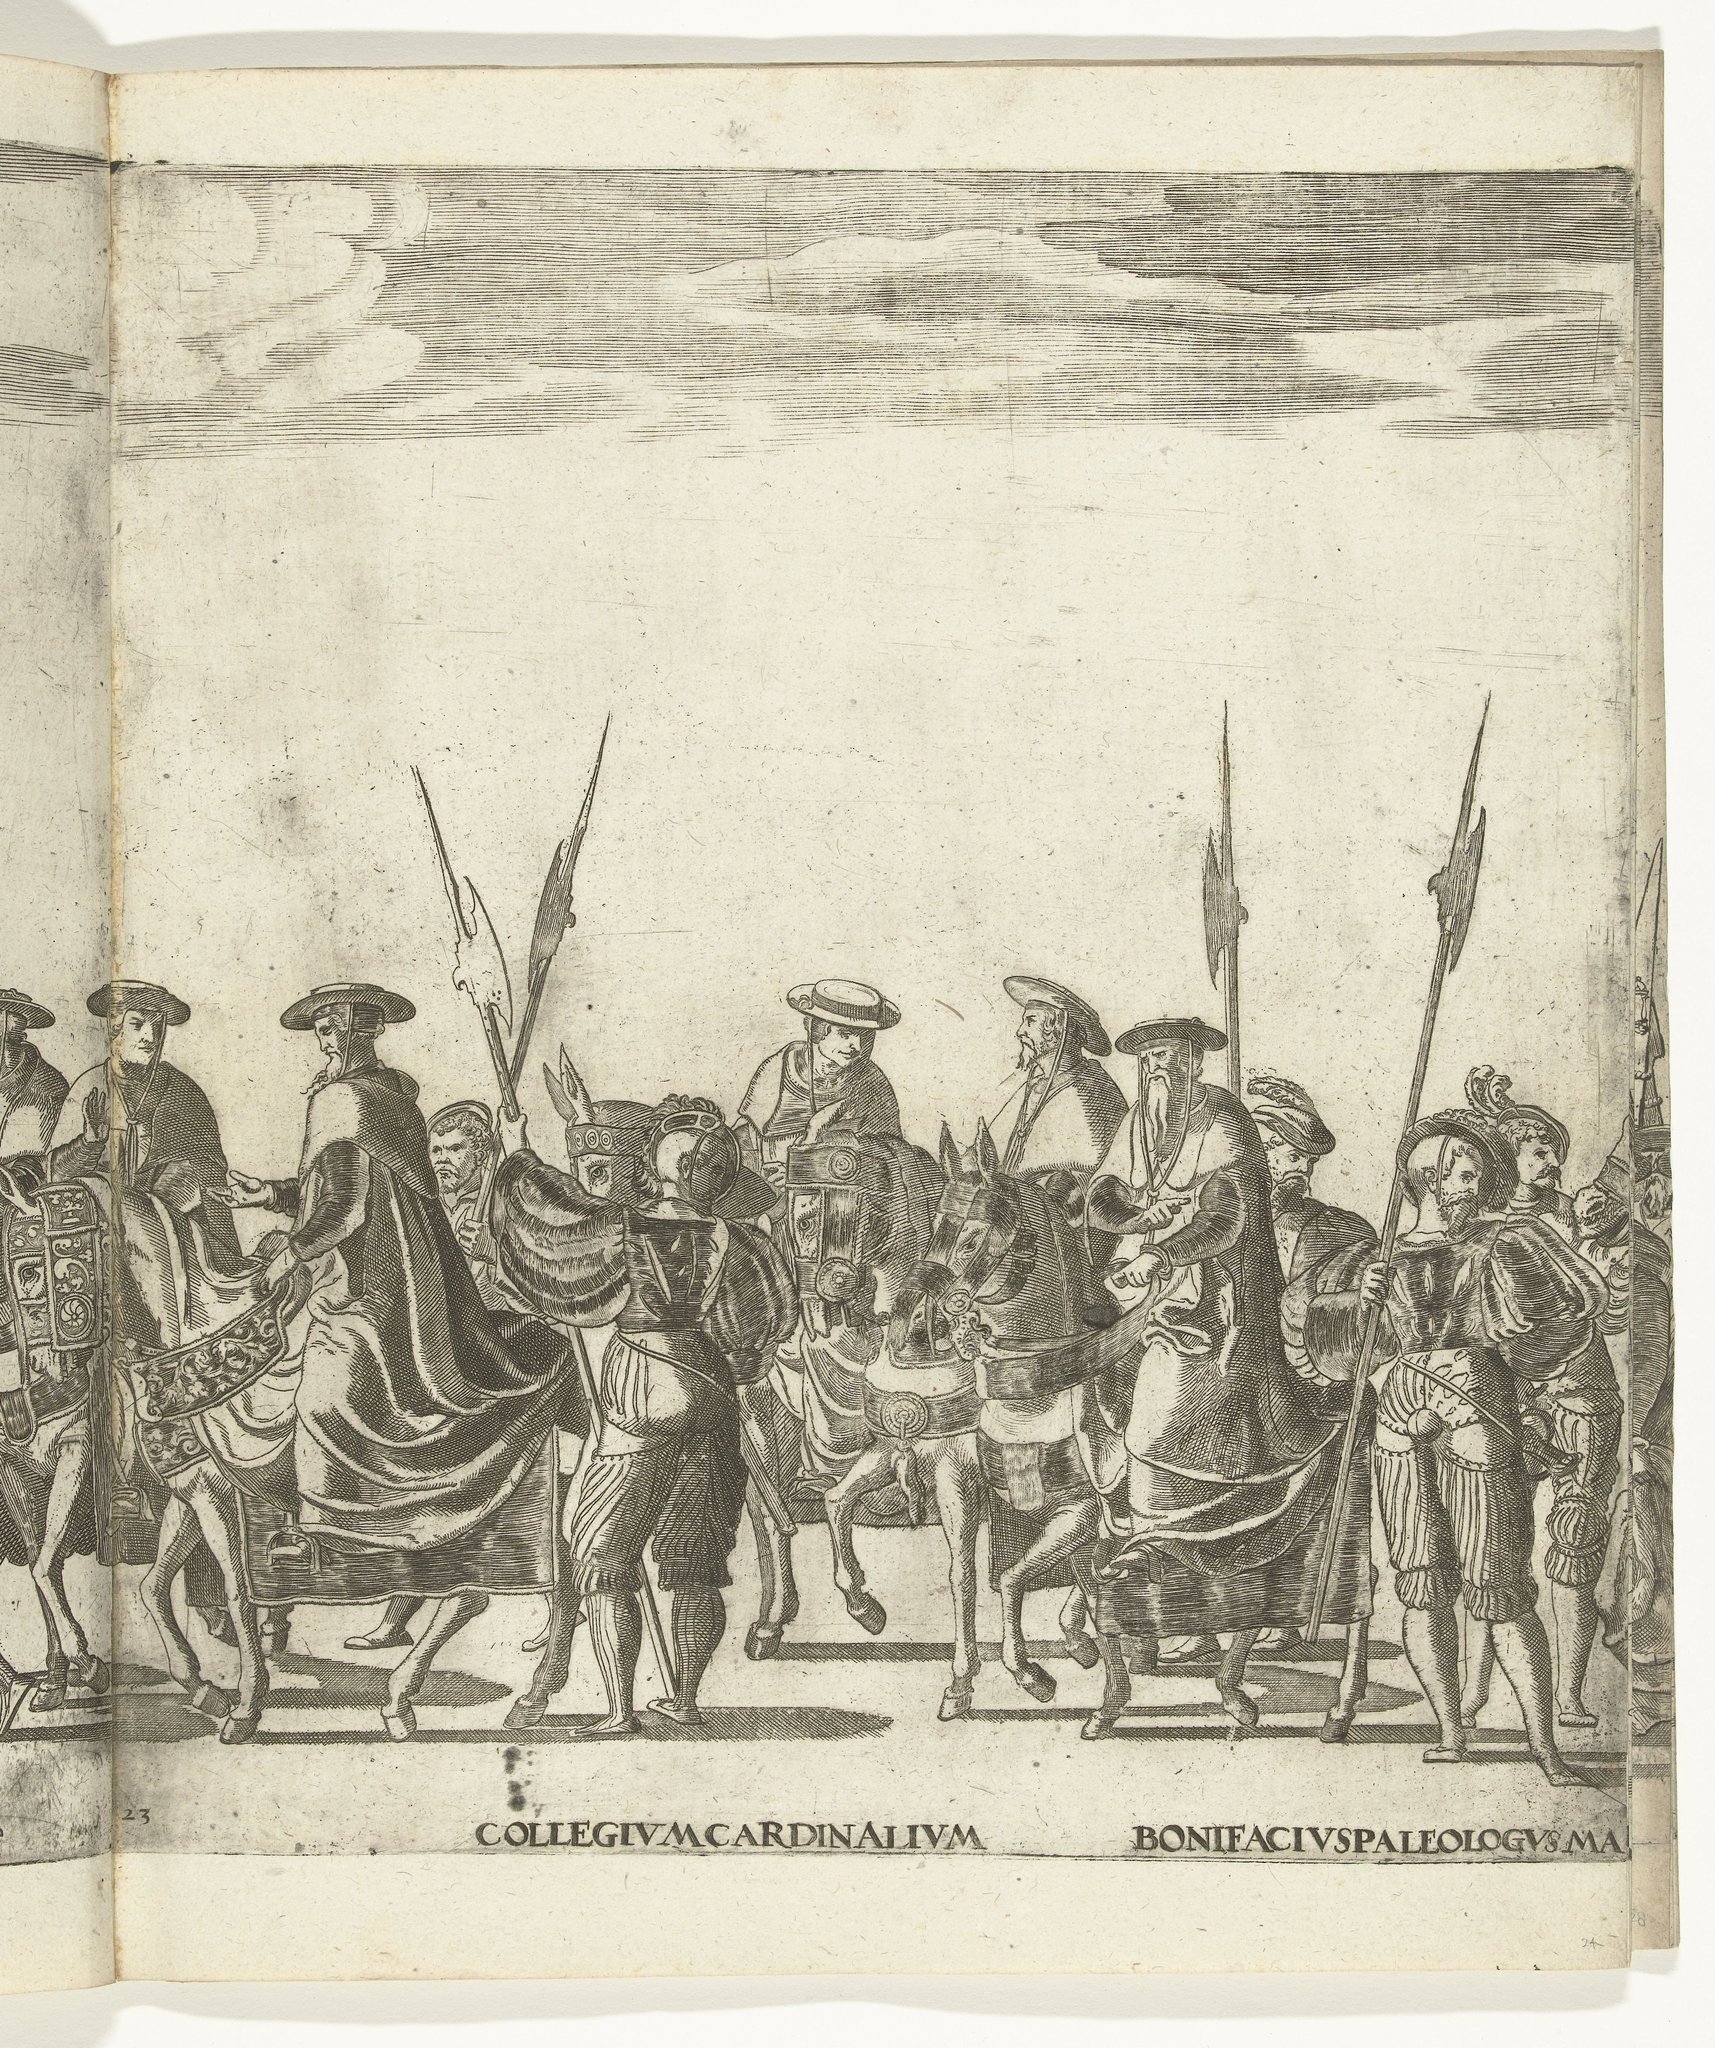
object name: print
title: College van kardinalen, plaat 23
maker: nicolaas hogenberg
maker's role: draughtsman, painter, print maker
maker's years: 1500-1539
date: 1530-1536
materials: paper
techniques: engraving, etching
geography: mechelen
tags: ghent, charles v (holy roman emperor and king of spain), festivities (+ parade, pageant, cavalcade ~ festive activities)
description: In plaats van de geneologische afstamming van Karel V in het huis van Oostenrijk is in deze uitgave bovenin de platen een nieuw lucht gegraveerd. De platen zijn genummerd 1-38. Deze uitgave is later dan die van Hondius. De platen zijn aanelkaar geplakt en vormen zo één lang (opgevouwen) fries. Het opgevouwen fries ligt los in een map.